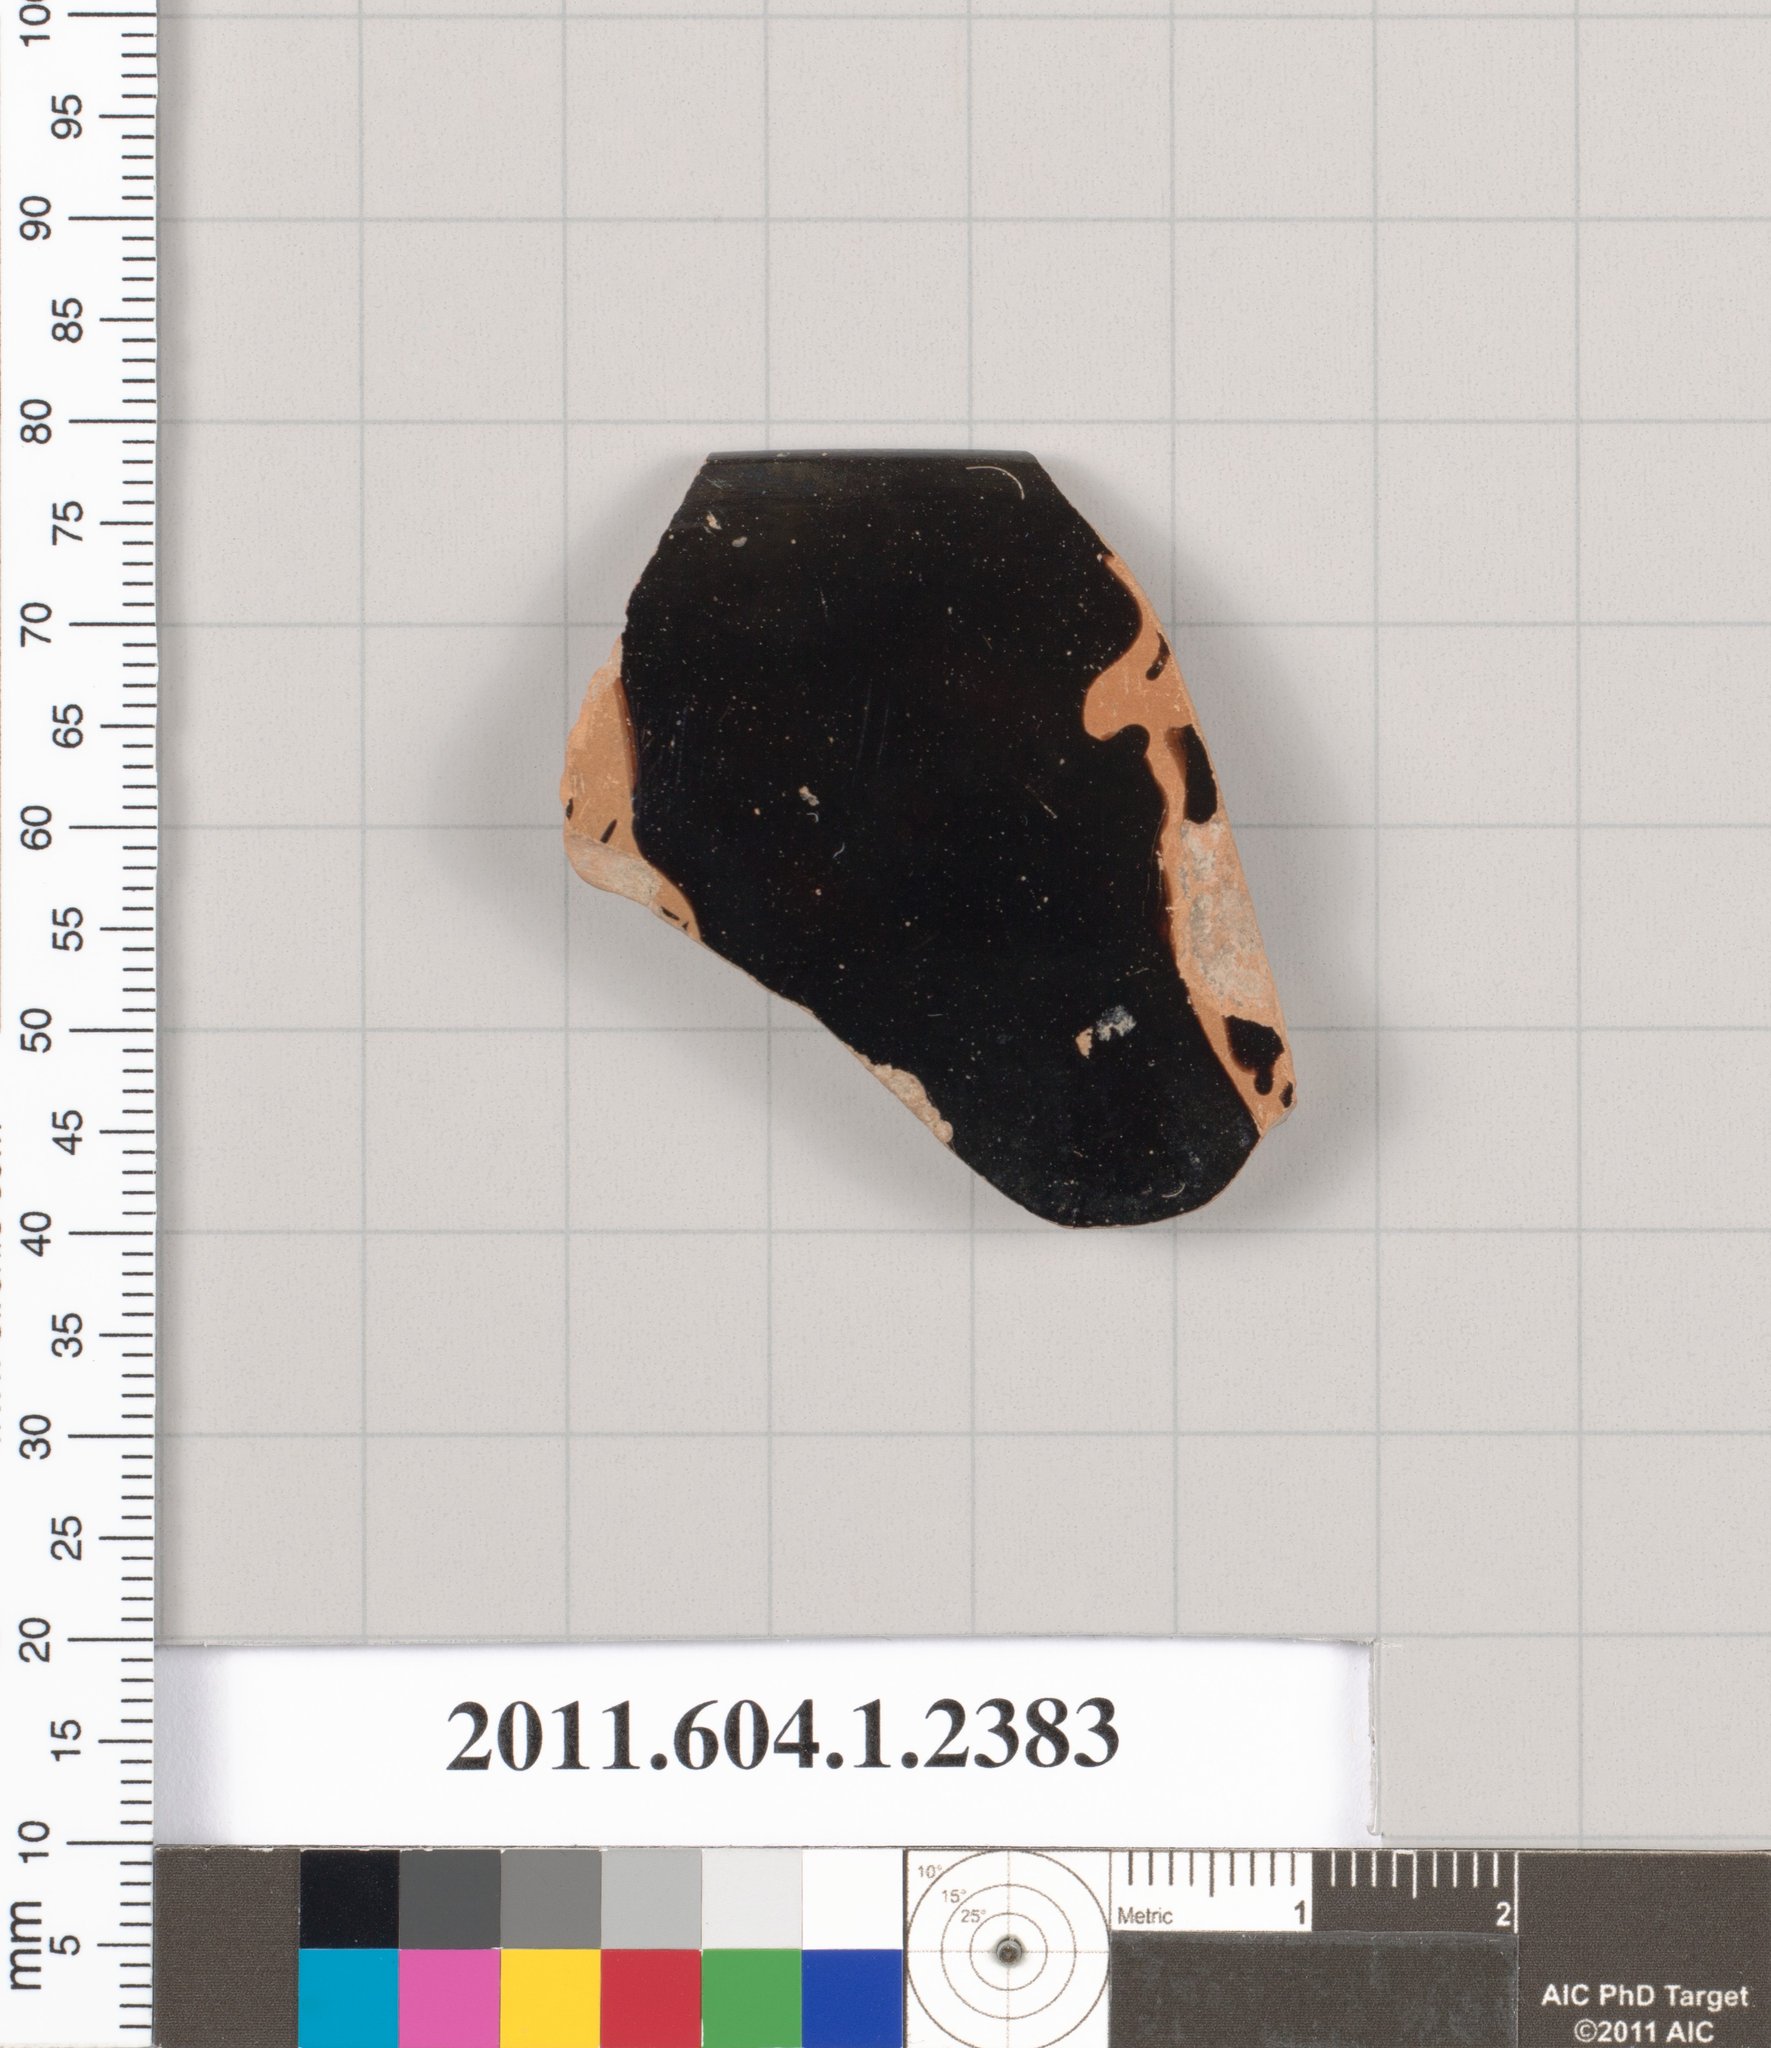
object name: kylix fragment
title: Terracotta rim fragment of a kylix (drinking cup)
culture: greek, attic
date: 475-451 BCE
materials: terracotta